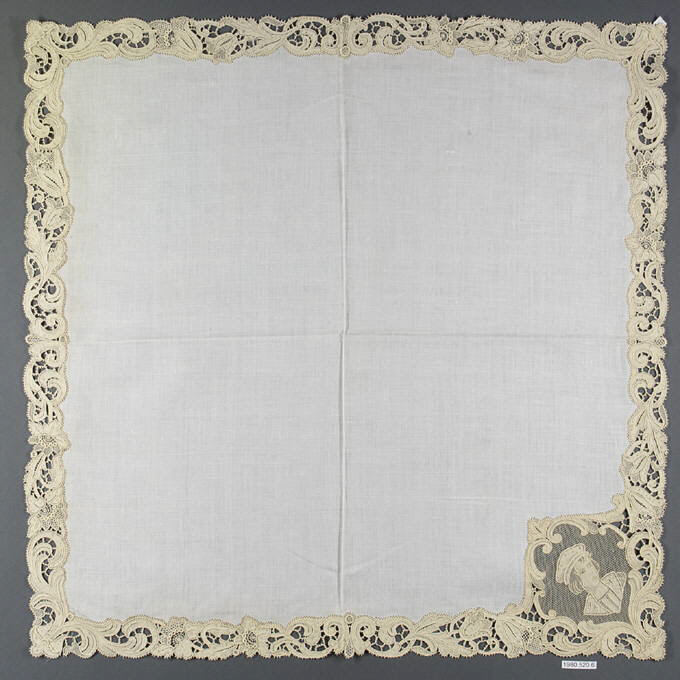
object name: napkin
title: Napkin (from a set of table linens)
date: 1867-1900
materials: linen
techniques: lace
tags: portraits